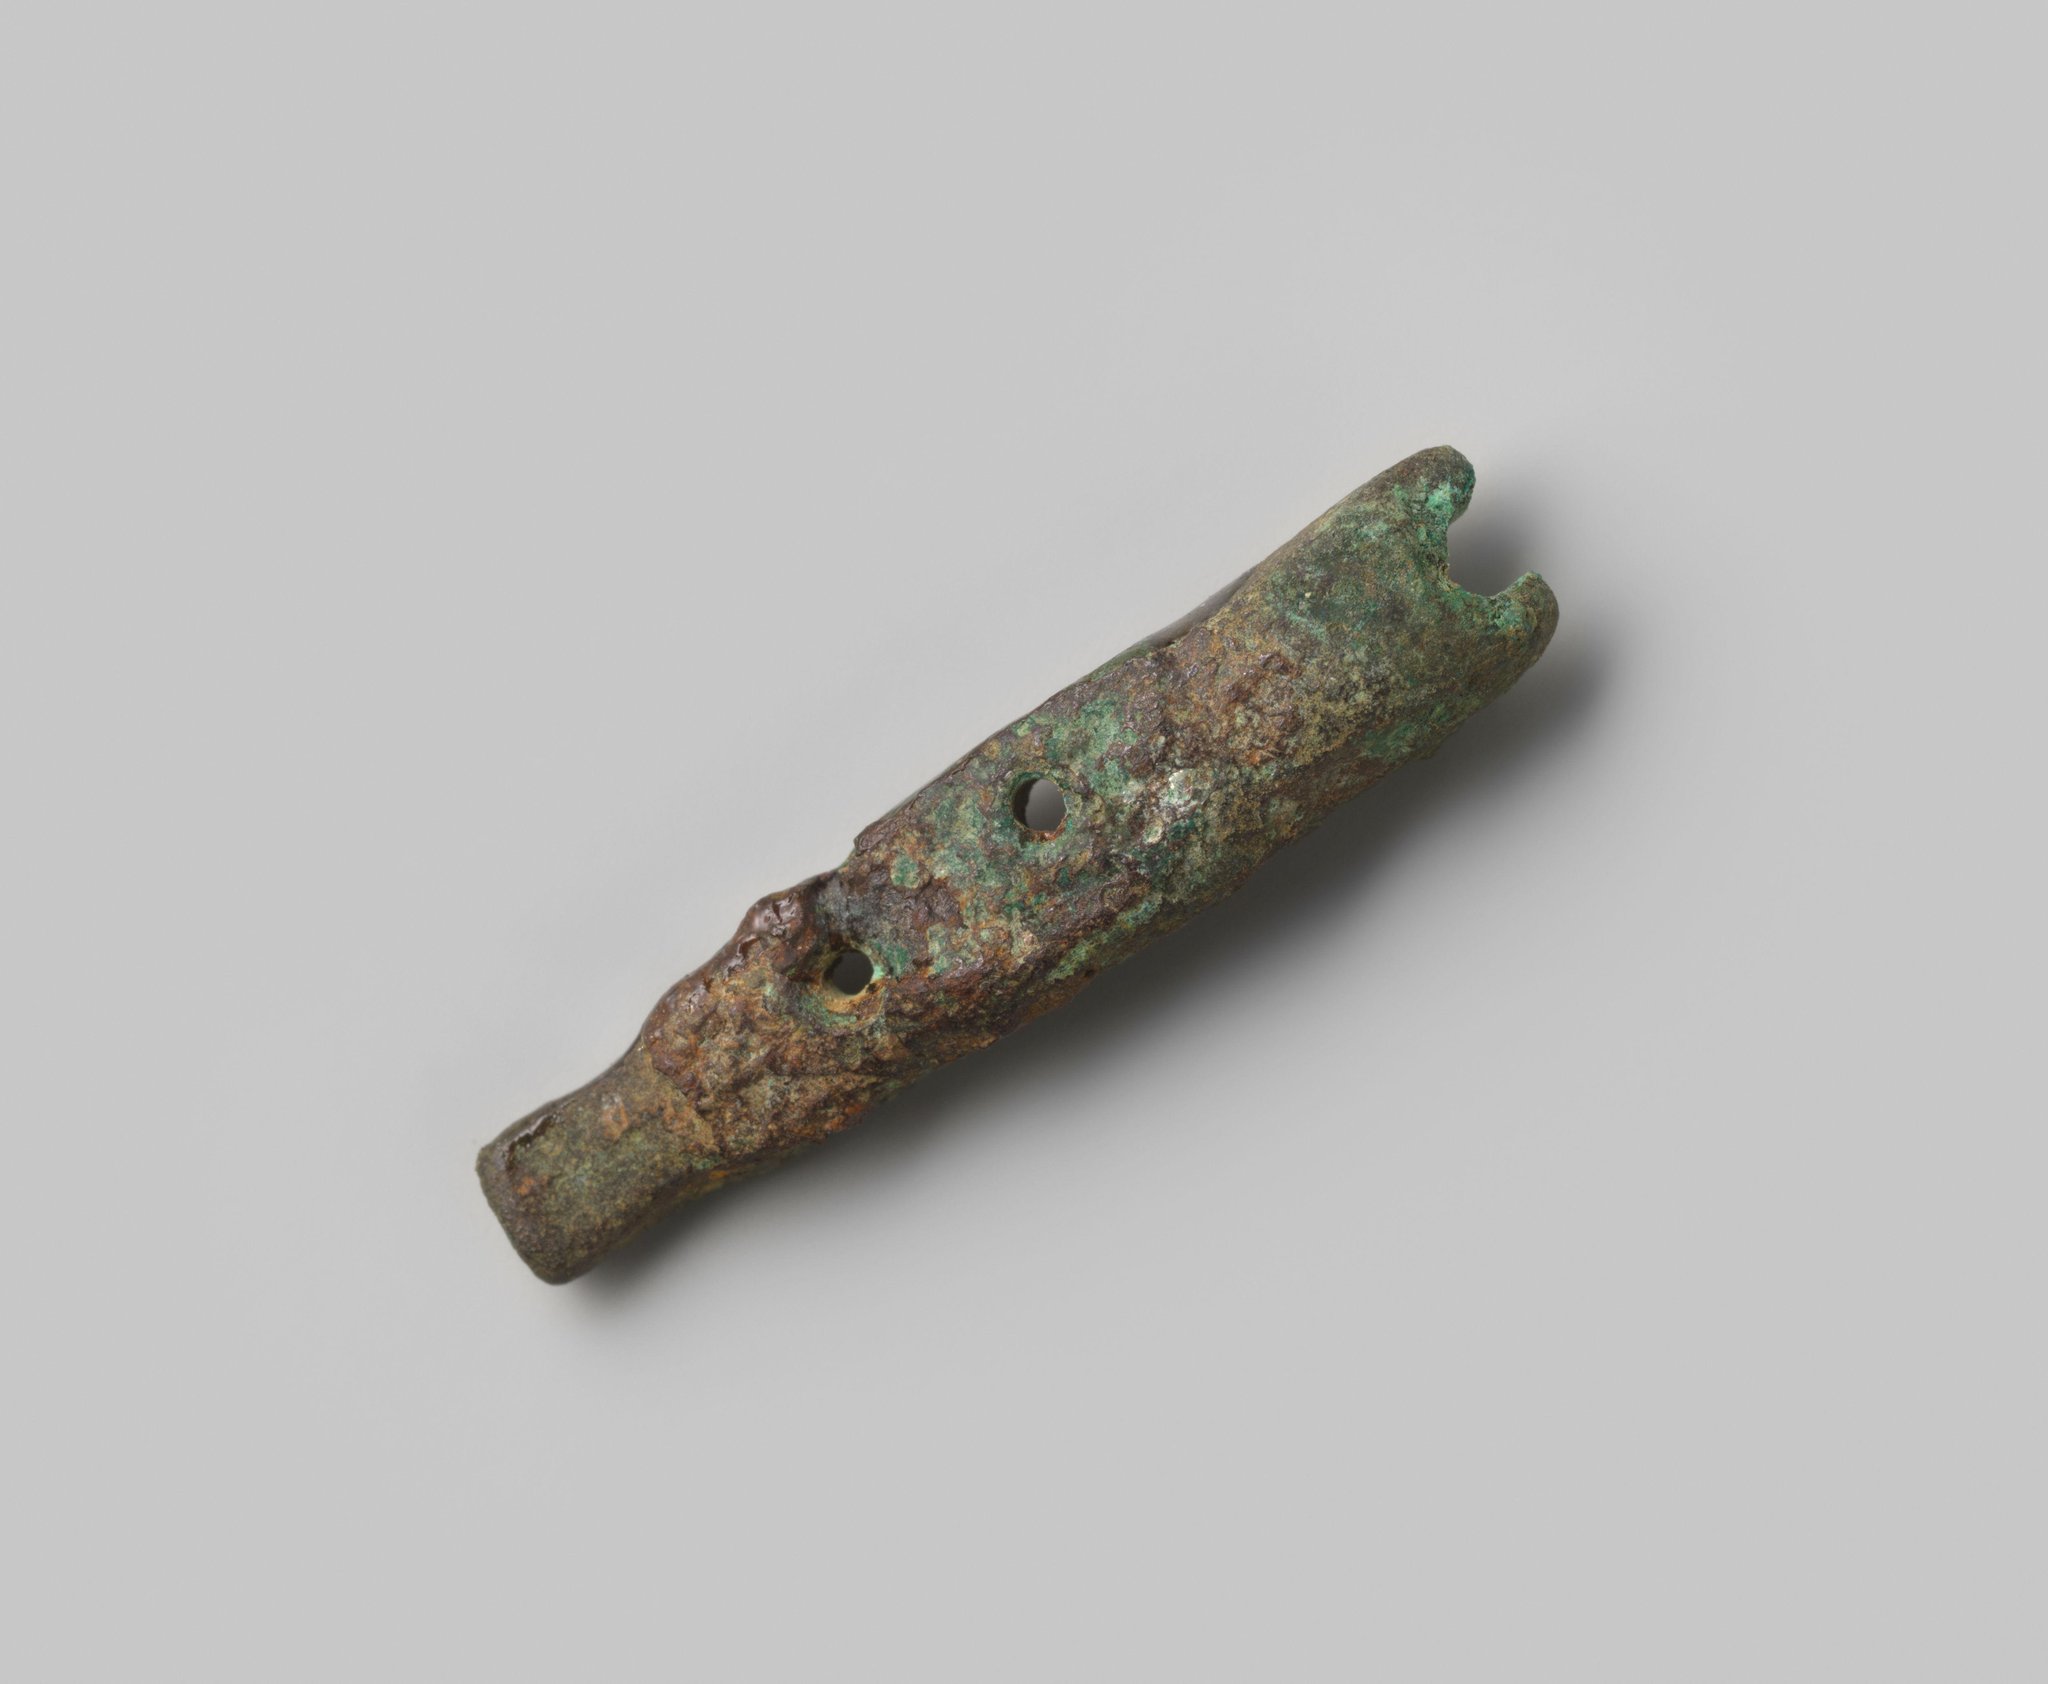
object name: sluitgewicht, pijlgewicht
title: Onderdeel slot van een sluitgewicht uit het wrak van de Oost-Indiëvaarder Hollandia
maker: Anonymous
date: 1700-1743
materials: copper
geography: netherlands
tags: verenigde oostindische compagnie, hollandia (schip), annet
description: Weight, cupweight, locks and hinges; fragm of lock, id. NG 1980-27H737.